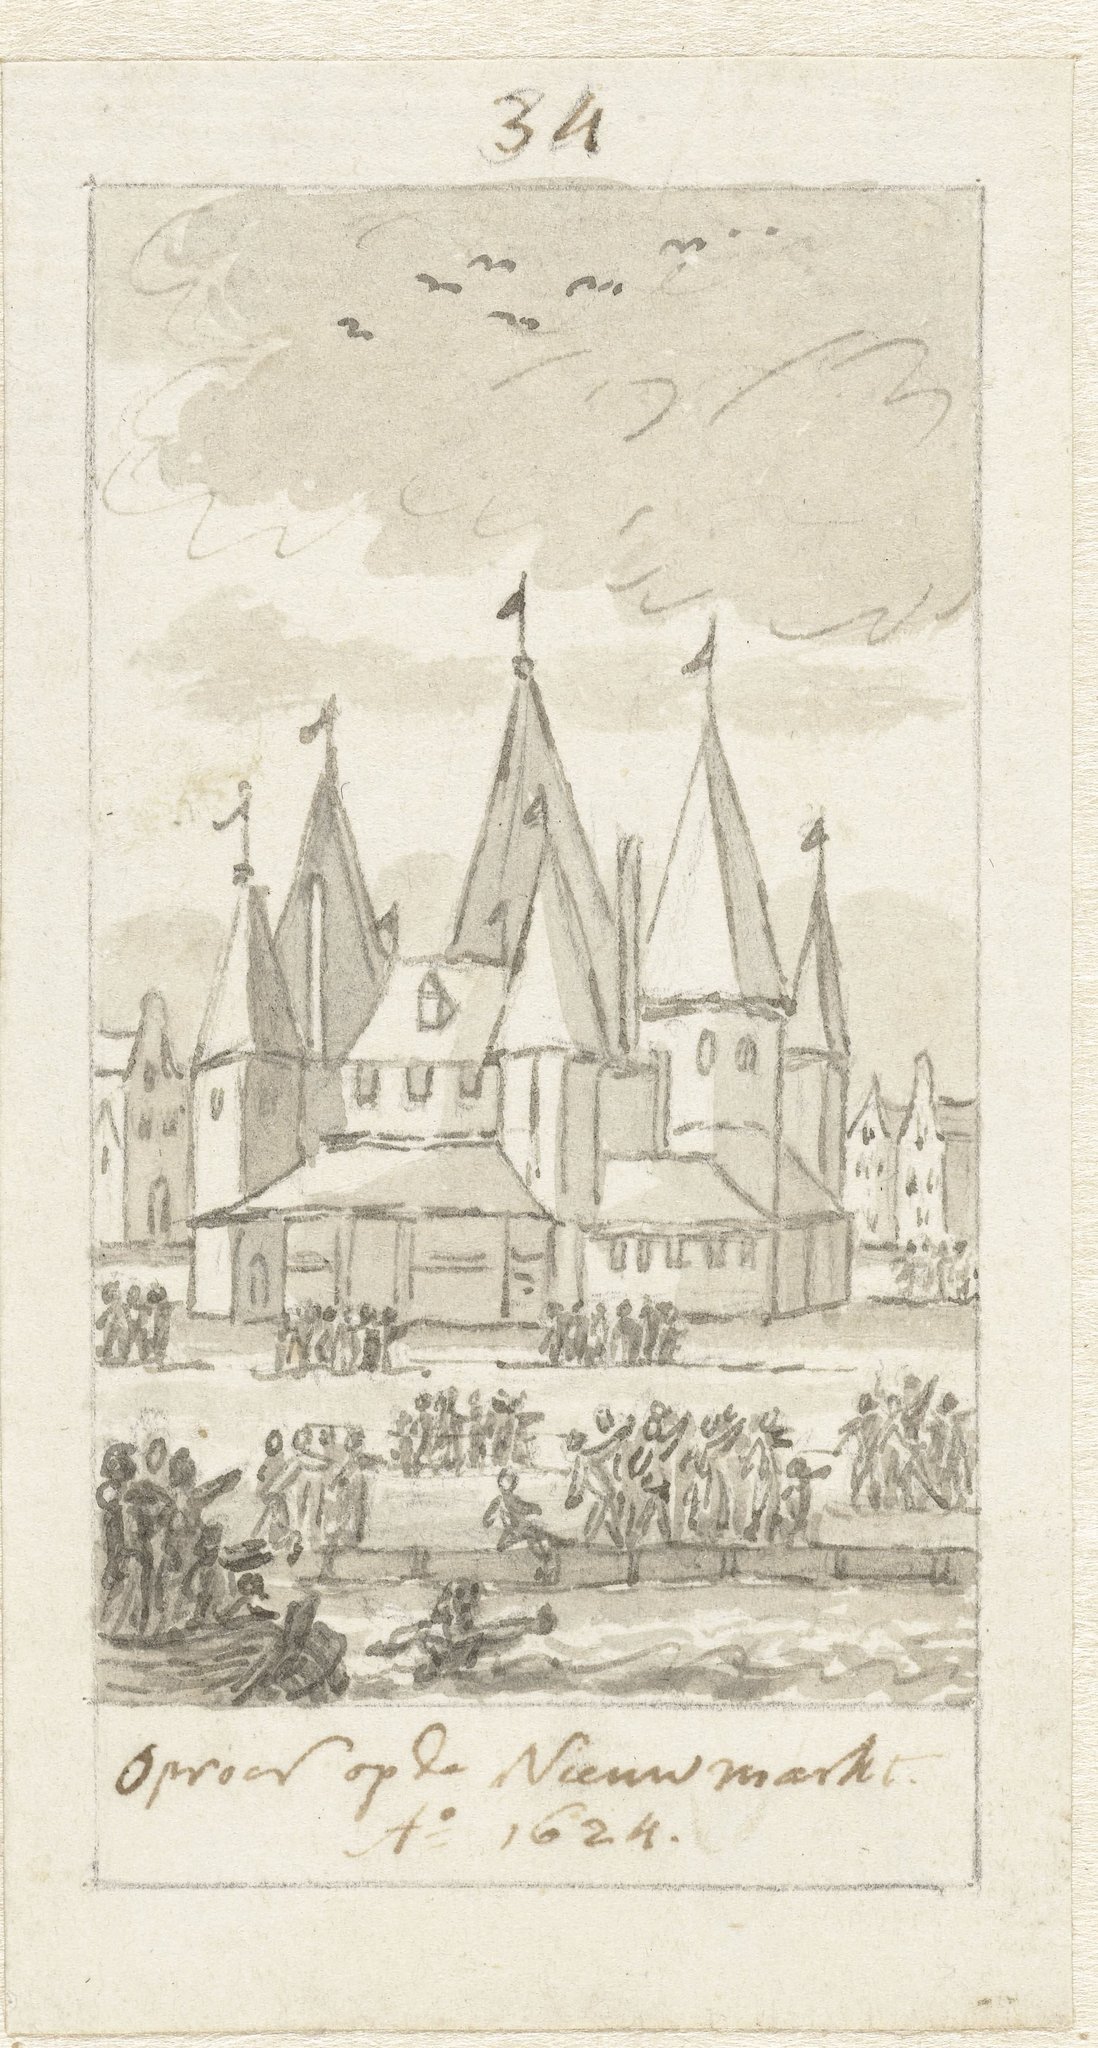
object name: historieplaat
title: Oproer op de Nieuwmarkt over een gewaande tovenares, 1624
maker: simon fokke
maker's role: draughtsman, print maker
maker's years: 1712-1784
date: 1722-1784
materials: ink, paper, pencil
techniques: brush, pen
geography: northern netherlands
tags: discovery, finding of witch ~ witch-hunt, street-fights, riots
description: Oproer op de Nieuwmarkt over een gewaande tovenares, 1624. Opstootjes op de Nieuwmarkt met de Sint Antoniespoort. Genummerd 34. Ontwerp voor een prent.